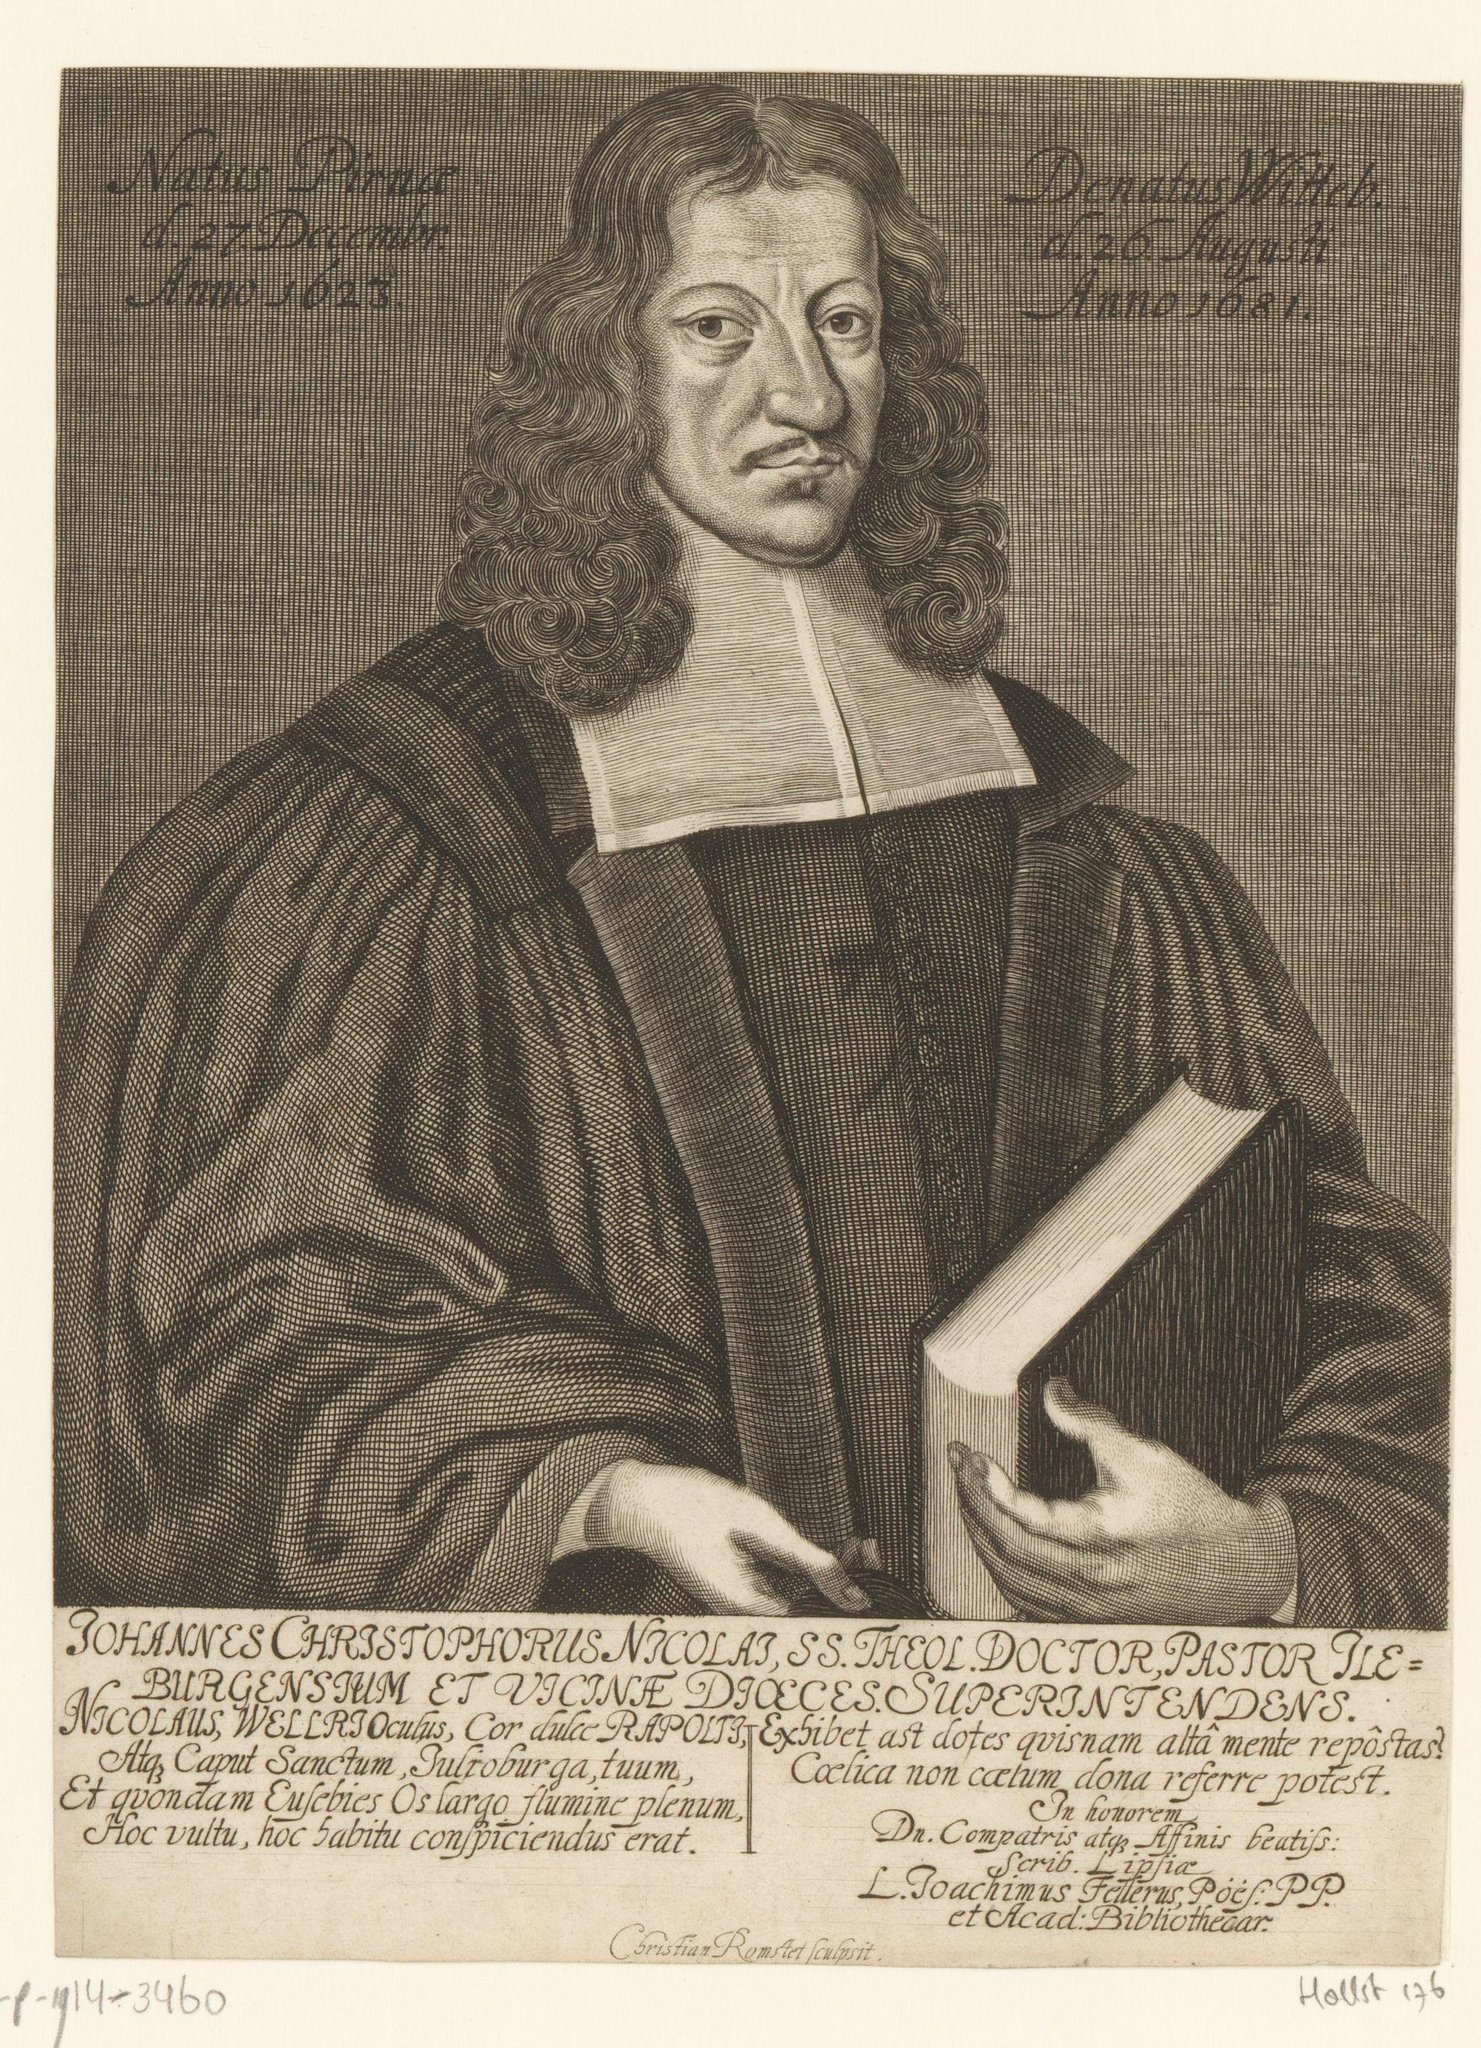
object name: print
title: Portret van Johann Christoph Nicolai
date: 1665-1721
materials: paper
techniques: engraving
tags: theologian, historical persons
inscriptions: collector's mark: Lugt 2228